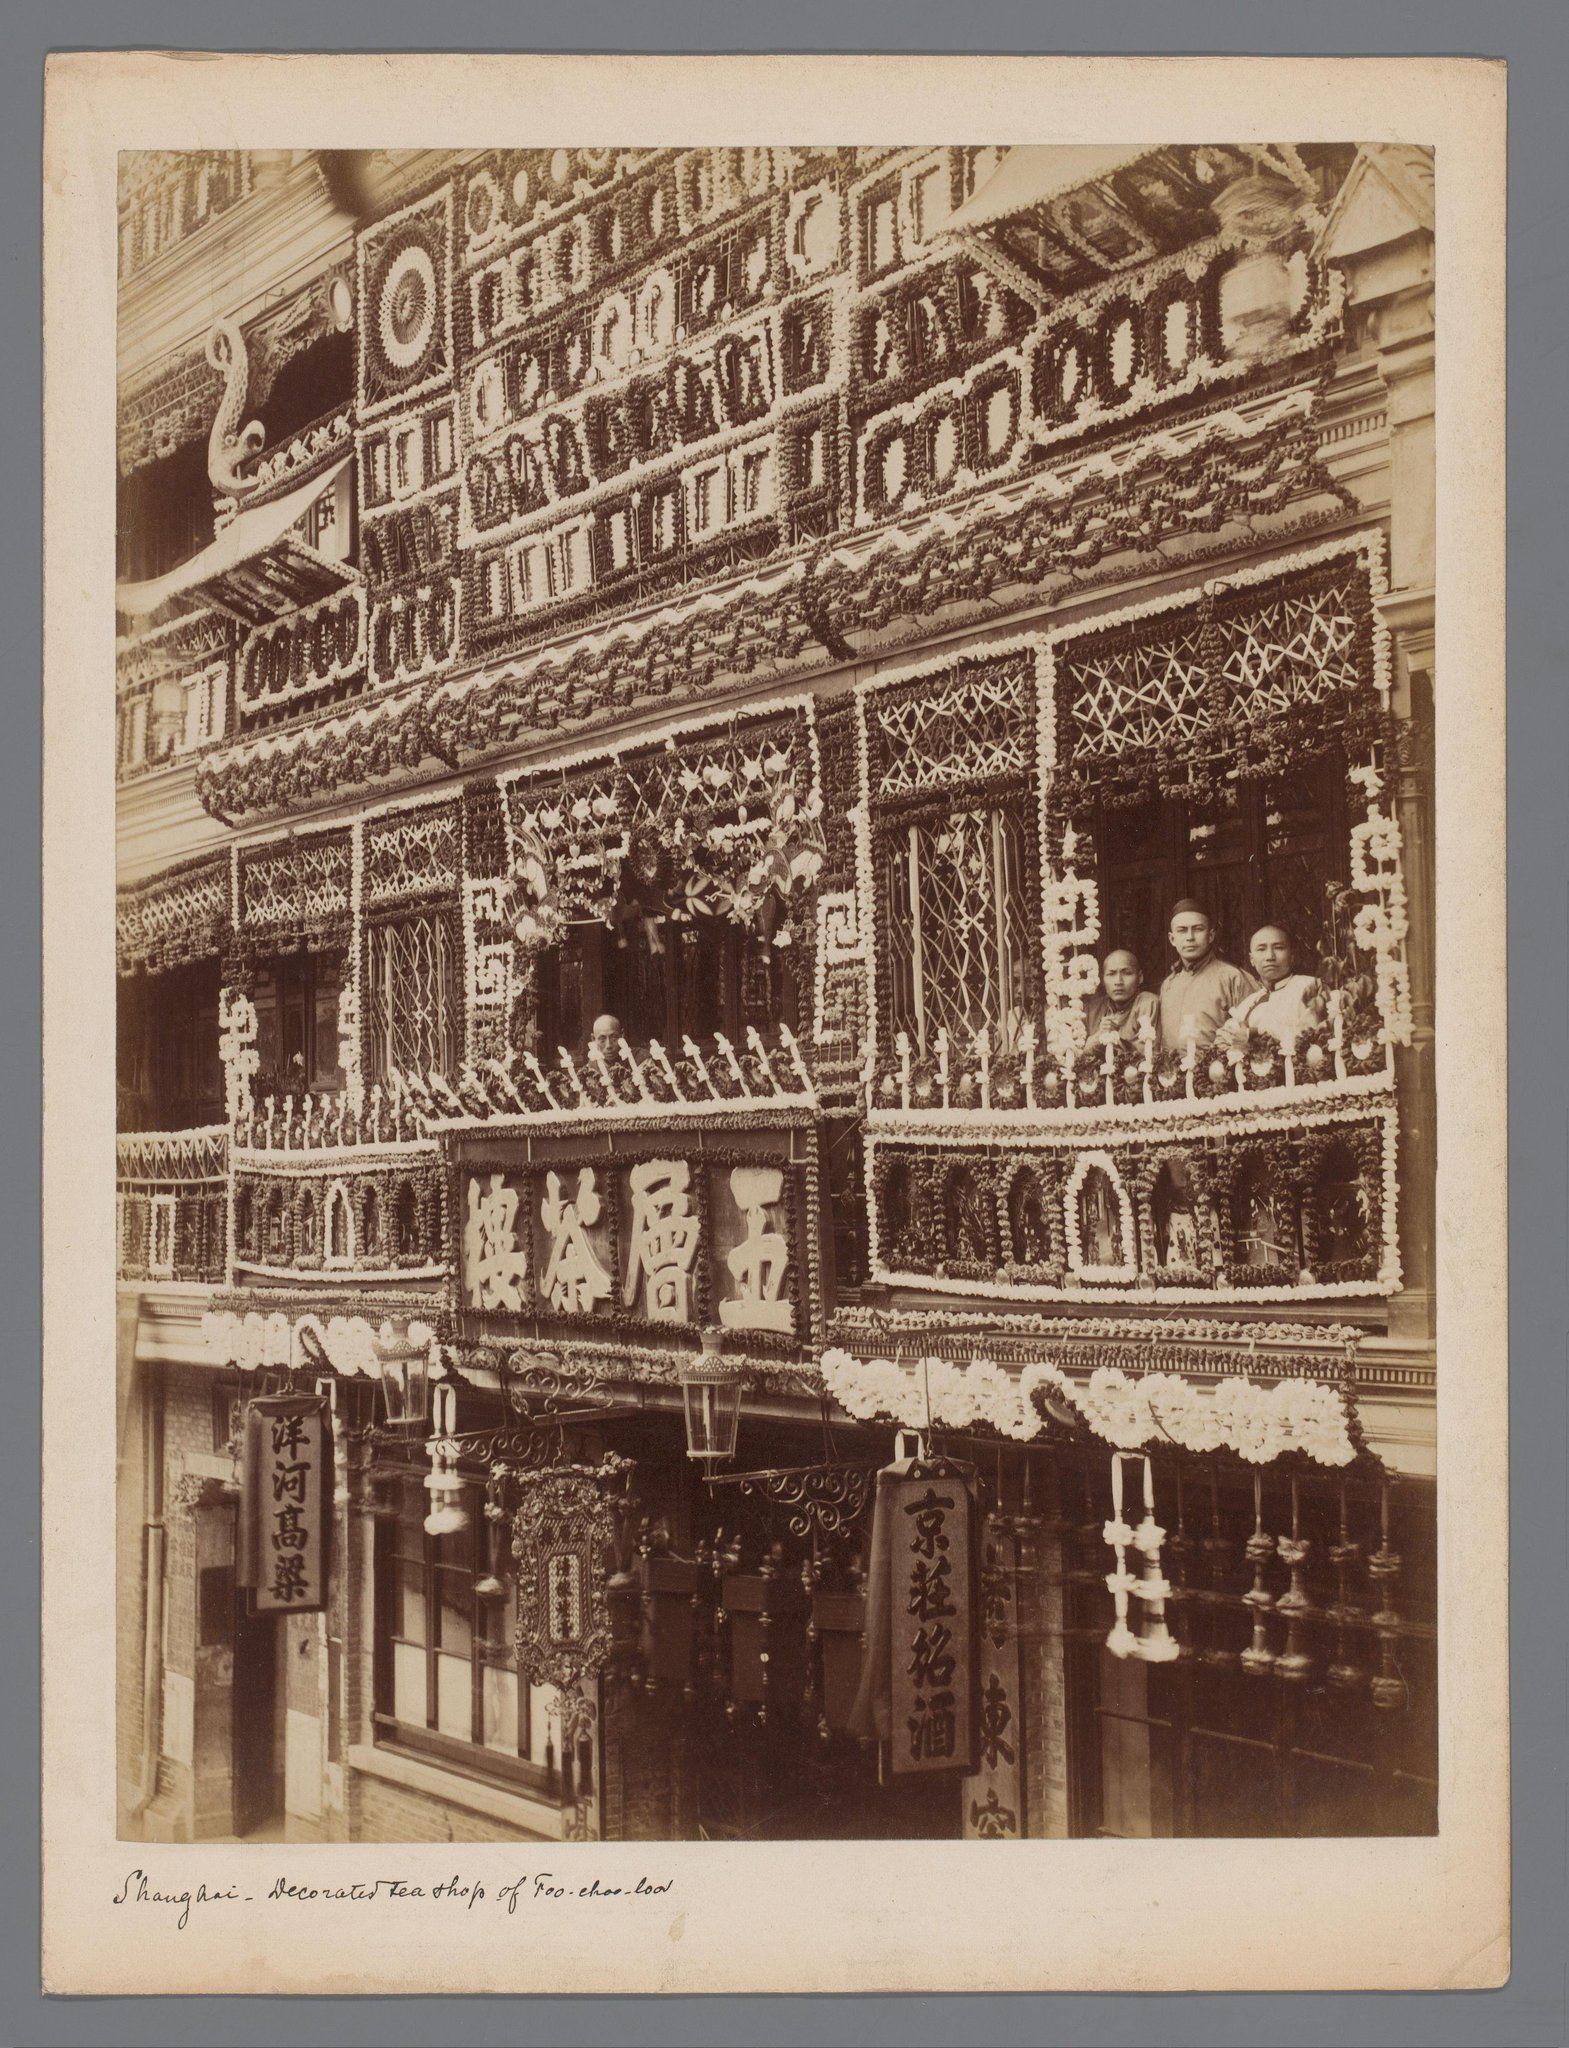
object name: photograph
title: Gedecoreerd theehuis van Foo-Choo-Low te Shanghai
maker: Anonymous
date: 1850-1900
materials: cardboard, photographic support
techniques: albumen print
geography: shanghai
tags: inn, coffee-house, public house, etc.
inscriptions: annotation: ‘Shanghai-Decorated tea shop of Foo-choo-low’